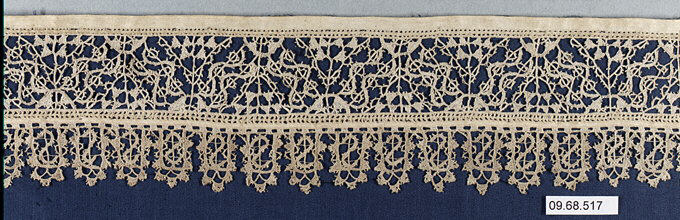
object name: fragment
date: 1801-1900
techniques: lace